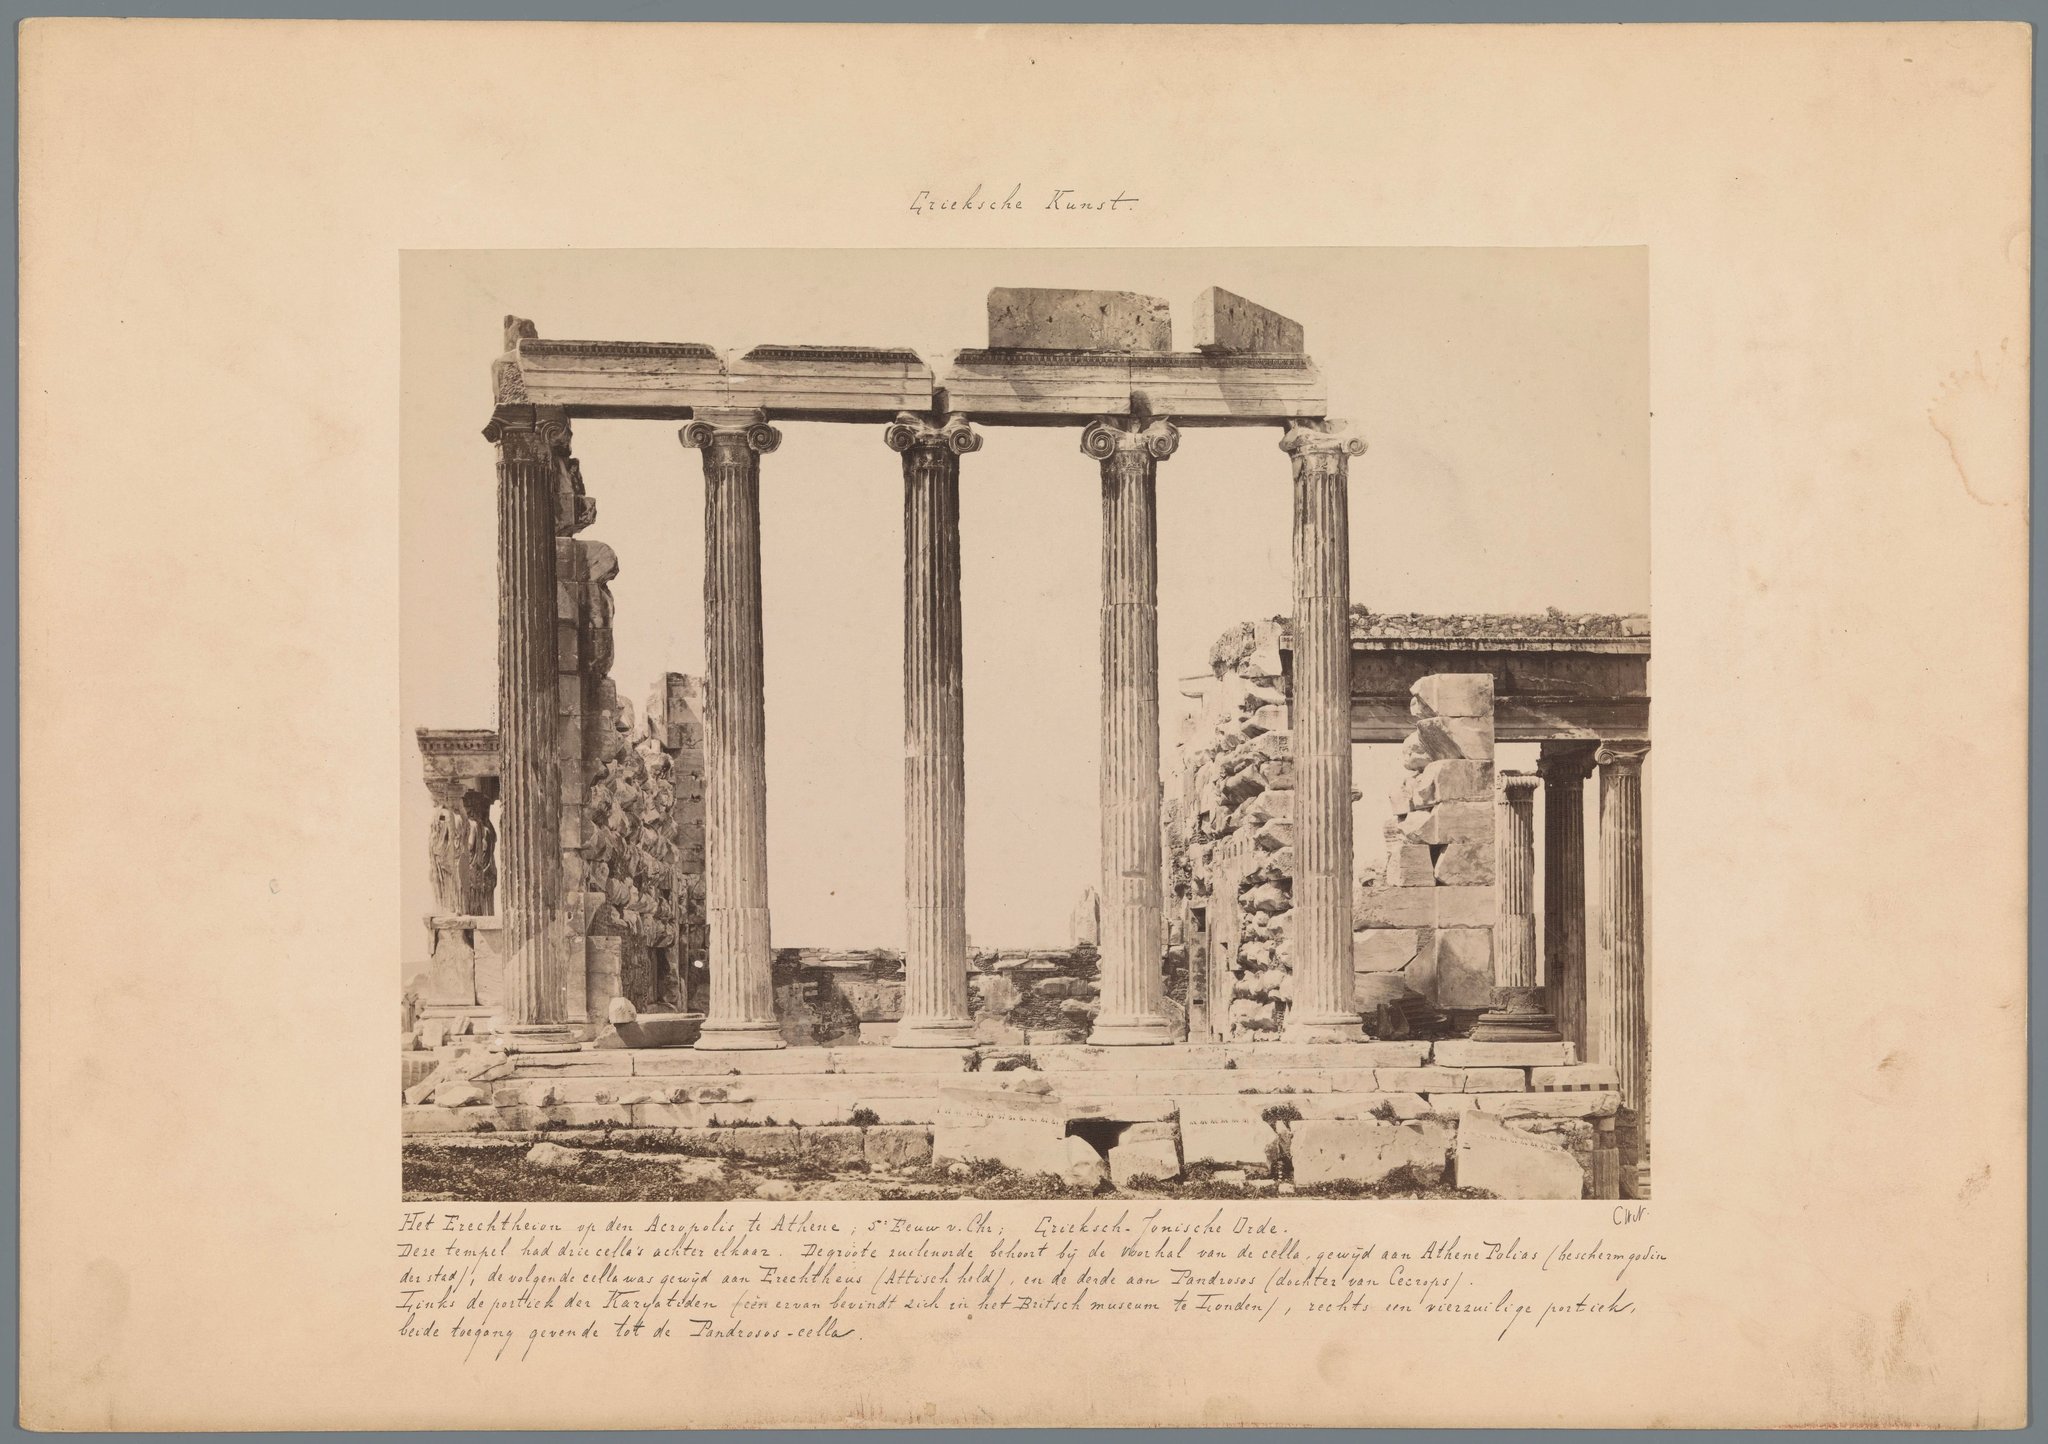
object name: photograph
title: Ruïne van het Erechtheion op de Akropolis te Athene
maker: Anonymous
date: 1875-1900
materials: cardboard, photographic support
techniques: albumen print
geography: acropolis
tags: ornaments ~ art, column, pillar ~ architecture, temple, shrine ~ non-christian religions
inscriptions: collector's mark: ‘INSTITUUT VOOR KUNST- NIJVERHEIDSONDERWIJS GABRIËL METSUSTRAAT No. 16. AMSTERDAM’, inscription: ‘Grieksche Kunst. Het Erechtheion op den Acropolis te Athene (...) rechts een vierzuilige portiek, beide toegang gevende tot de Pandrosos-cella.’, collector's mark: ‘KUNSTNIJVERHEIDSCHOOL QUELLINUS AMSTERDAM FRANS HALSSTRAAT 14.’, inscription: ‘CWN.’